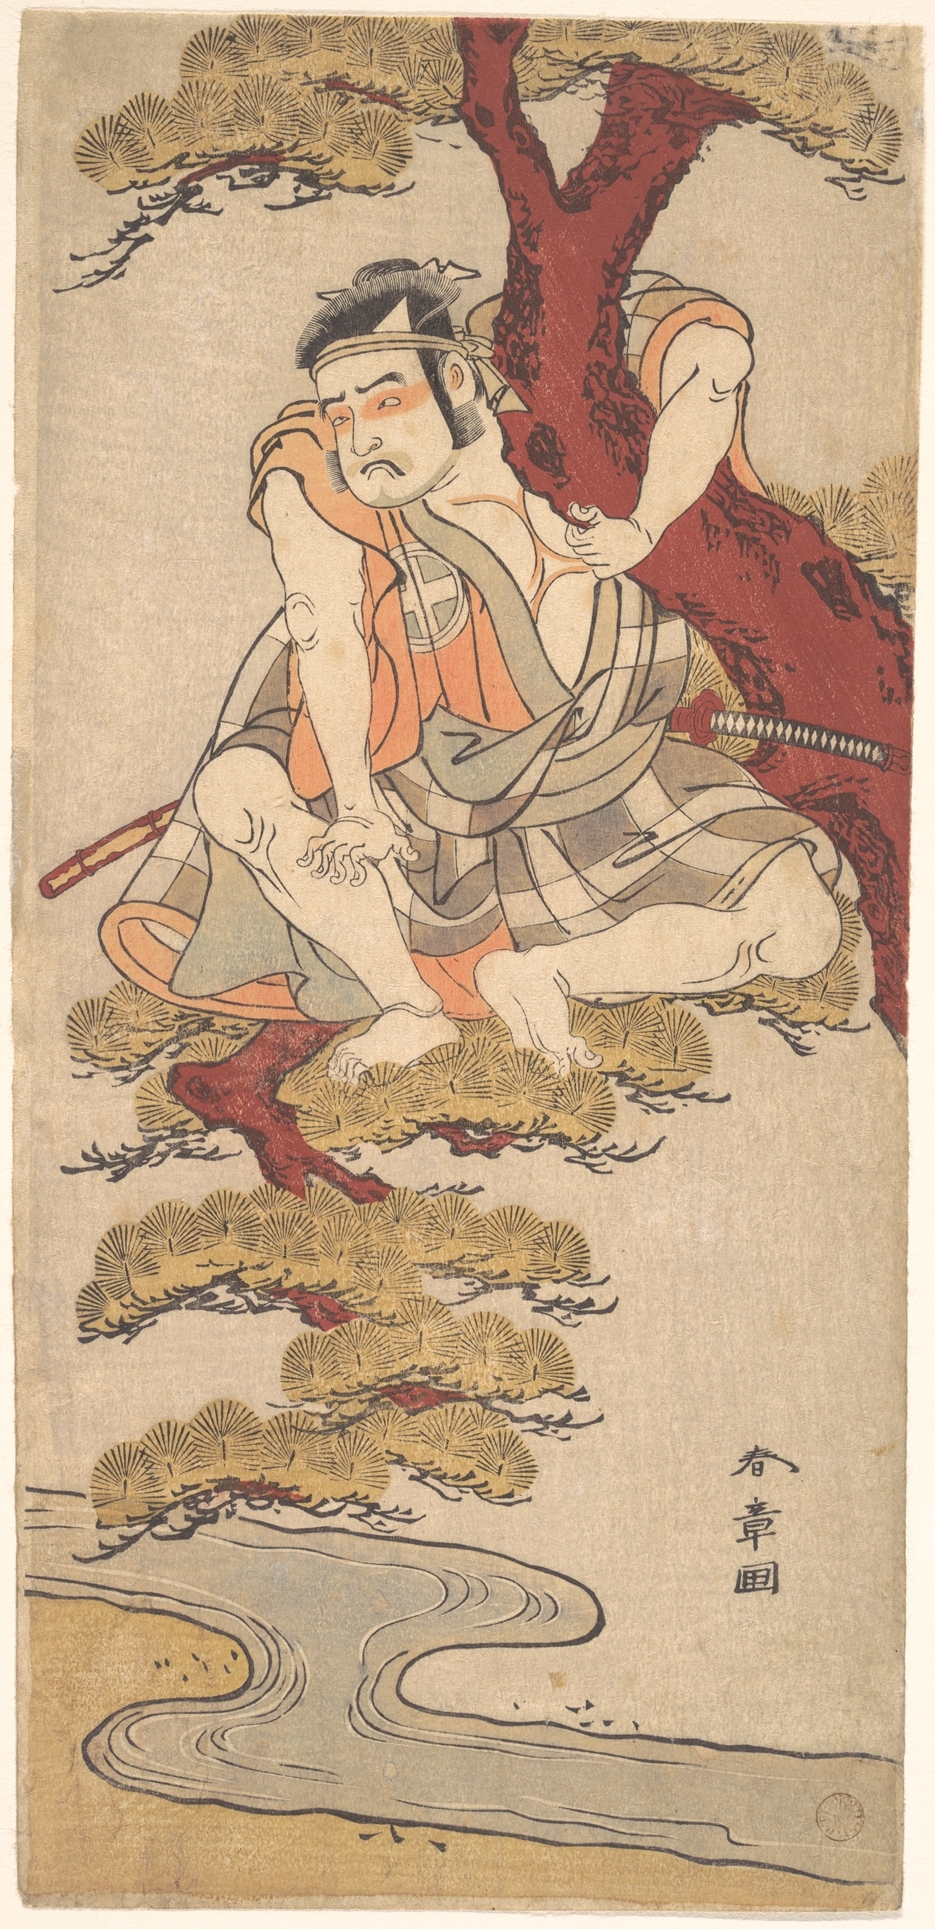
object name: woodblock print nishiki e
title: The Actor Otani Hiroemon III Watching from the Branches of a Pine Tree Overhanging a Stream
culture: japanese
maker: katsukawa shunshō 勝川春章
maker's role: artist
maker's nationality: japanese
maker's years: 1726-1792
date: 1775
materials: ink, paper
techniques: nishiki e, woodblock print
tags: men,trees,actors